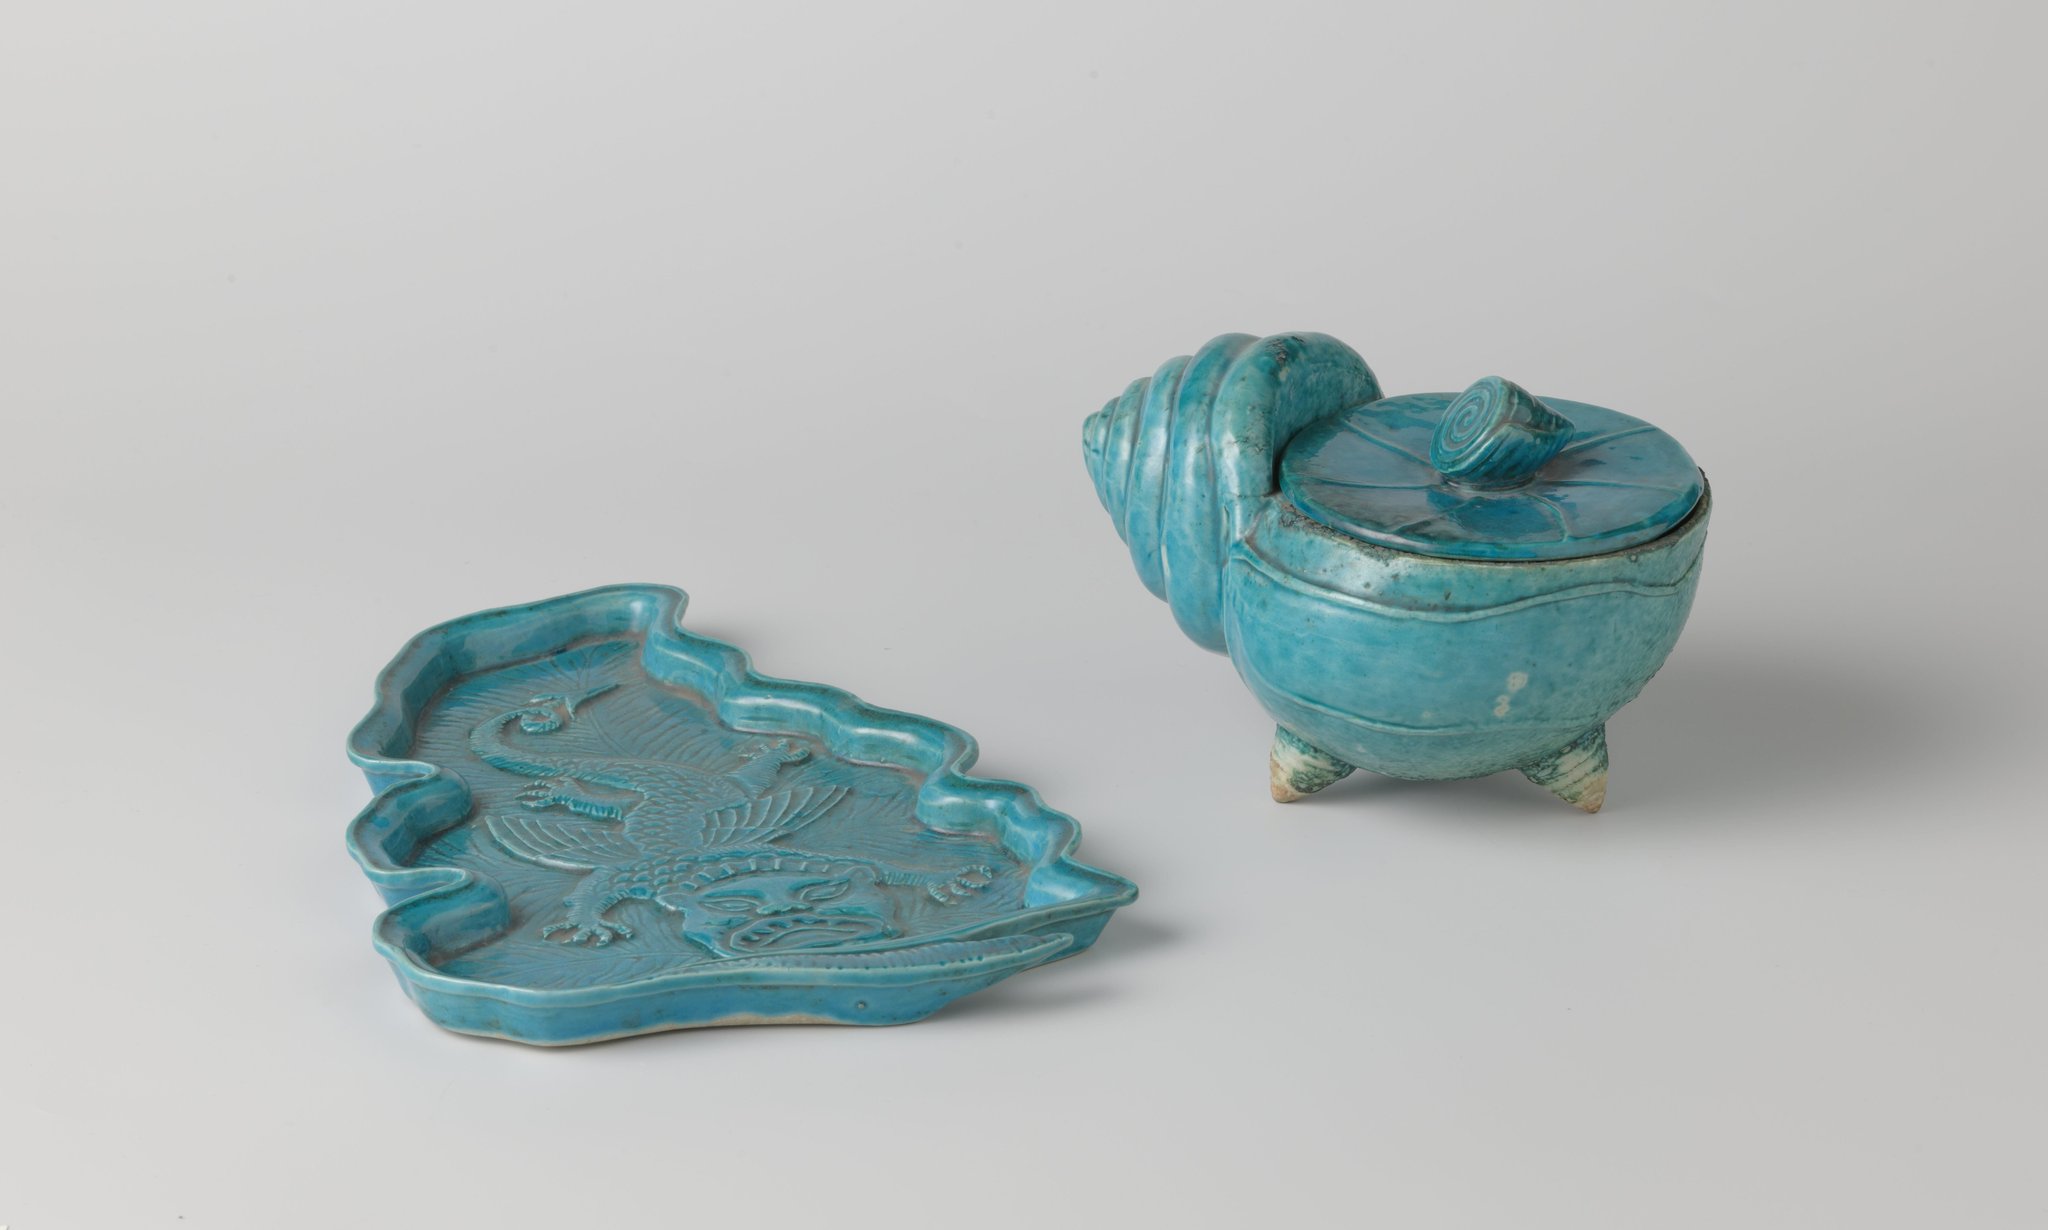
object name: covered bowl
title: Scallop-shaped covered bowl with a leaf-shaped stand with dragon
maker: Anonymous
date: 1775-1799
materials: glaze, porcelain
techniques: firing, forming, vitrification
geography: china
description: AK-NM-6432 Kom met deksel en (niet bijpassende) onderschotel • Gekleurd – monochroom porselein • Onderdeel van Royers porseleincollectie Omdat er wordt getwijfeld of de vaasjes AK-NM-7370 en 6371 wel 18de-eeuws zijn en tot Royers verzameling hebben behoord, is deze schelp eigenlijk het enige monochrome stuk porselein dat we – zonder tegenbericht – beschouwen als onderdeel van Royers collecties. Zoals ook bij de gecraqueleerde kleine vazen het geval was, zijn vergelijkbare schelpen bekend met uitvoerige Franse vergulde monturen uit het midden van de 18de eeuw [Lunsingh Scheurleer 1980, afb. 283 (Walters Gallery), Krahl 1996, vol. II, nr. 263 (Rothschild collectie)]. Zoals bekend waren monochromen geliefd in Frankrijk, en niet in Nederland. De Franse smaak voor porselein nam aan het eind van de 17de eeuw al een andere wending dan die in Nederland. Het ging in Frankrijk in het algemeen om kleinere aantallen stukken – vaak gemonteerd – die fraai combineerden met andere kostbaarheden in een collectie. Porselein sloot aan op hardstenen voorwerpen. Terwijl in Nederland de volle Marot-opstellingen nog lang na-ijlden, bestond in Frankrijk vaak al een grotere aandacht en kieskeurigheid voor afzonderlijke stukken. Dit komt naar voren in de manier waarop porselein in veilingcatalogi van vooraanstaande collecties beschreven wordt [Castelluccio 2013]. In de catalogus van de veiling van de collectie Randon de Boisset uit 1777 staat bijvoorbeeld: ‘par le ton doux & distingué de sa couleur… elle donne une variété brillant, étant artisement distribuée dans un cabinet.’ [Castelluccio 2013, p. 156 en cat. Randon de Bossiet 1777 (Lugtnr. 2652) vol. II, p. 74]. De voorliefde voor bleu céleste, de term die voor deze kleur blauw [maar ook voor het lichtere turkoois?] komt ook tot uitdrukking in de Sèvres schelpen, met precies deze vorm en een iets lichter maar toch zeer overeenkomstig glazuur. Deze Franse stukken kunnen gedateerd worden tussen 1763 en 1768 [Jarry 1981, pl. 125]. Voor de onderschotel heb ik geen vergelijkbare exemplaren in andere collecties kunnen vinden. De gedachtegang ‘dit is zo lelijk, dus het moet wel 19de-eeuws zijn’ is aanlokkelijk, maar de vreemde monsters zijn ook te vinden op een dekselpot met dit glazuur, voorzien van een Frans montuur uit het midden van de 18de eeuw [Jarry 1981, pl. 230]. Deze Franse manier van verzamelen was slechts van geringe betekenis voor de porseleinappreciatie in Nederland. Maar het lijkt me sterk dat het geheel onbekend was. Een zeer belangrijke porseleincollectie uit deze tijd, die van de gebroeders Bisschop (geveild 1771) lijkt deels gemodelleerd naar Frans voorbeeld. Natuurlijk keek men naar Franrijk, het internationale ijkpunt van de goede smaak! Ik ga er daarom vanuit dat ook Royer op de hoogte was van deze Franse smaak voor Chinees (en Japans) porselein en dat dat een stimulans kan zijn geweest deze schelp aan zijn collectie toe te voegen. Bronnen: Daniel François Lunsingh Scheurleer, Chinesisches und japanisches Porzellan in europäischen Fassungen, Braunschweig, 1980. Madeleine Jarry, Chinoiseries: le rayonnement du goût chinois sur les arts décoratifs des XVIIe et XVIIIe siècles, Fribourg, 1981. Regina Krahl, The Anthony de Rothschild collection of Chinese ceramics, Londen, 1996. Stephane Castelluccio, Collecting Chinese and Japanese porcelain in pre-revolutionary Paris, Los Angeles, 2013.